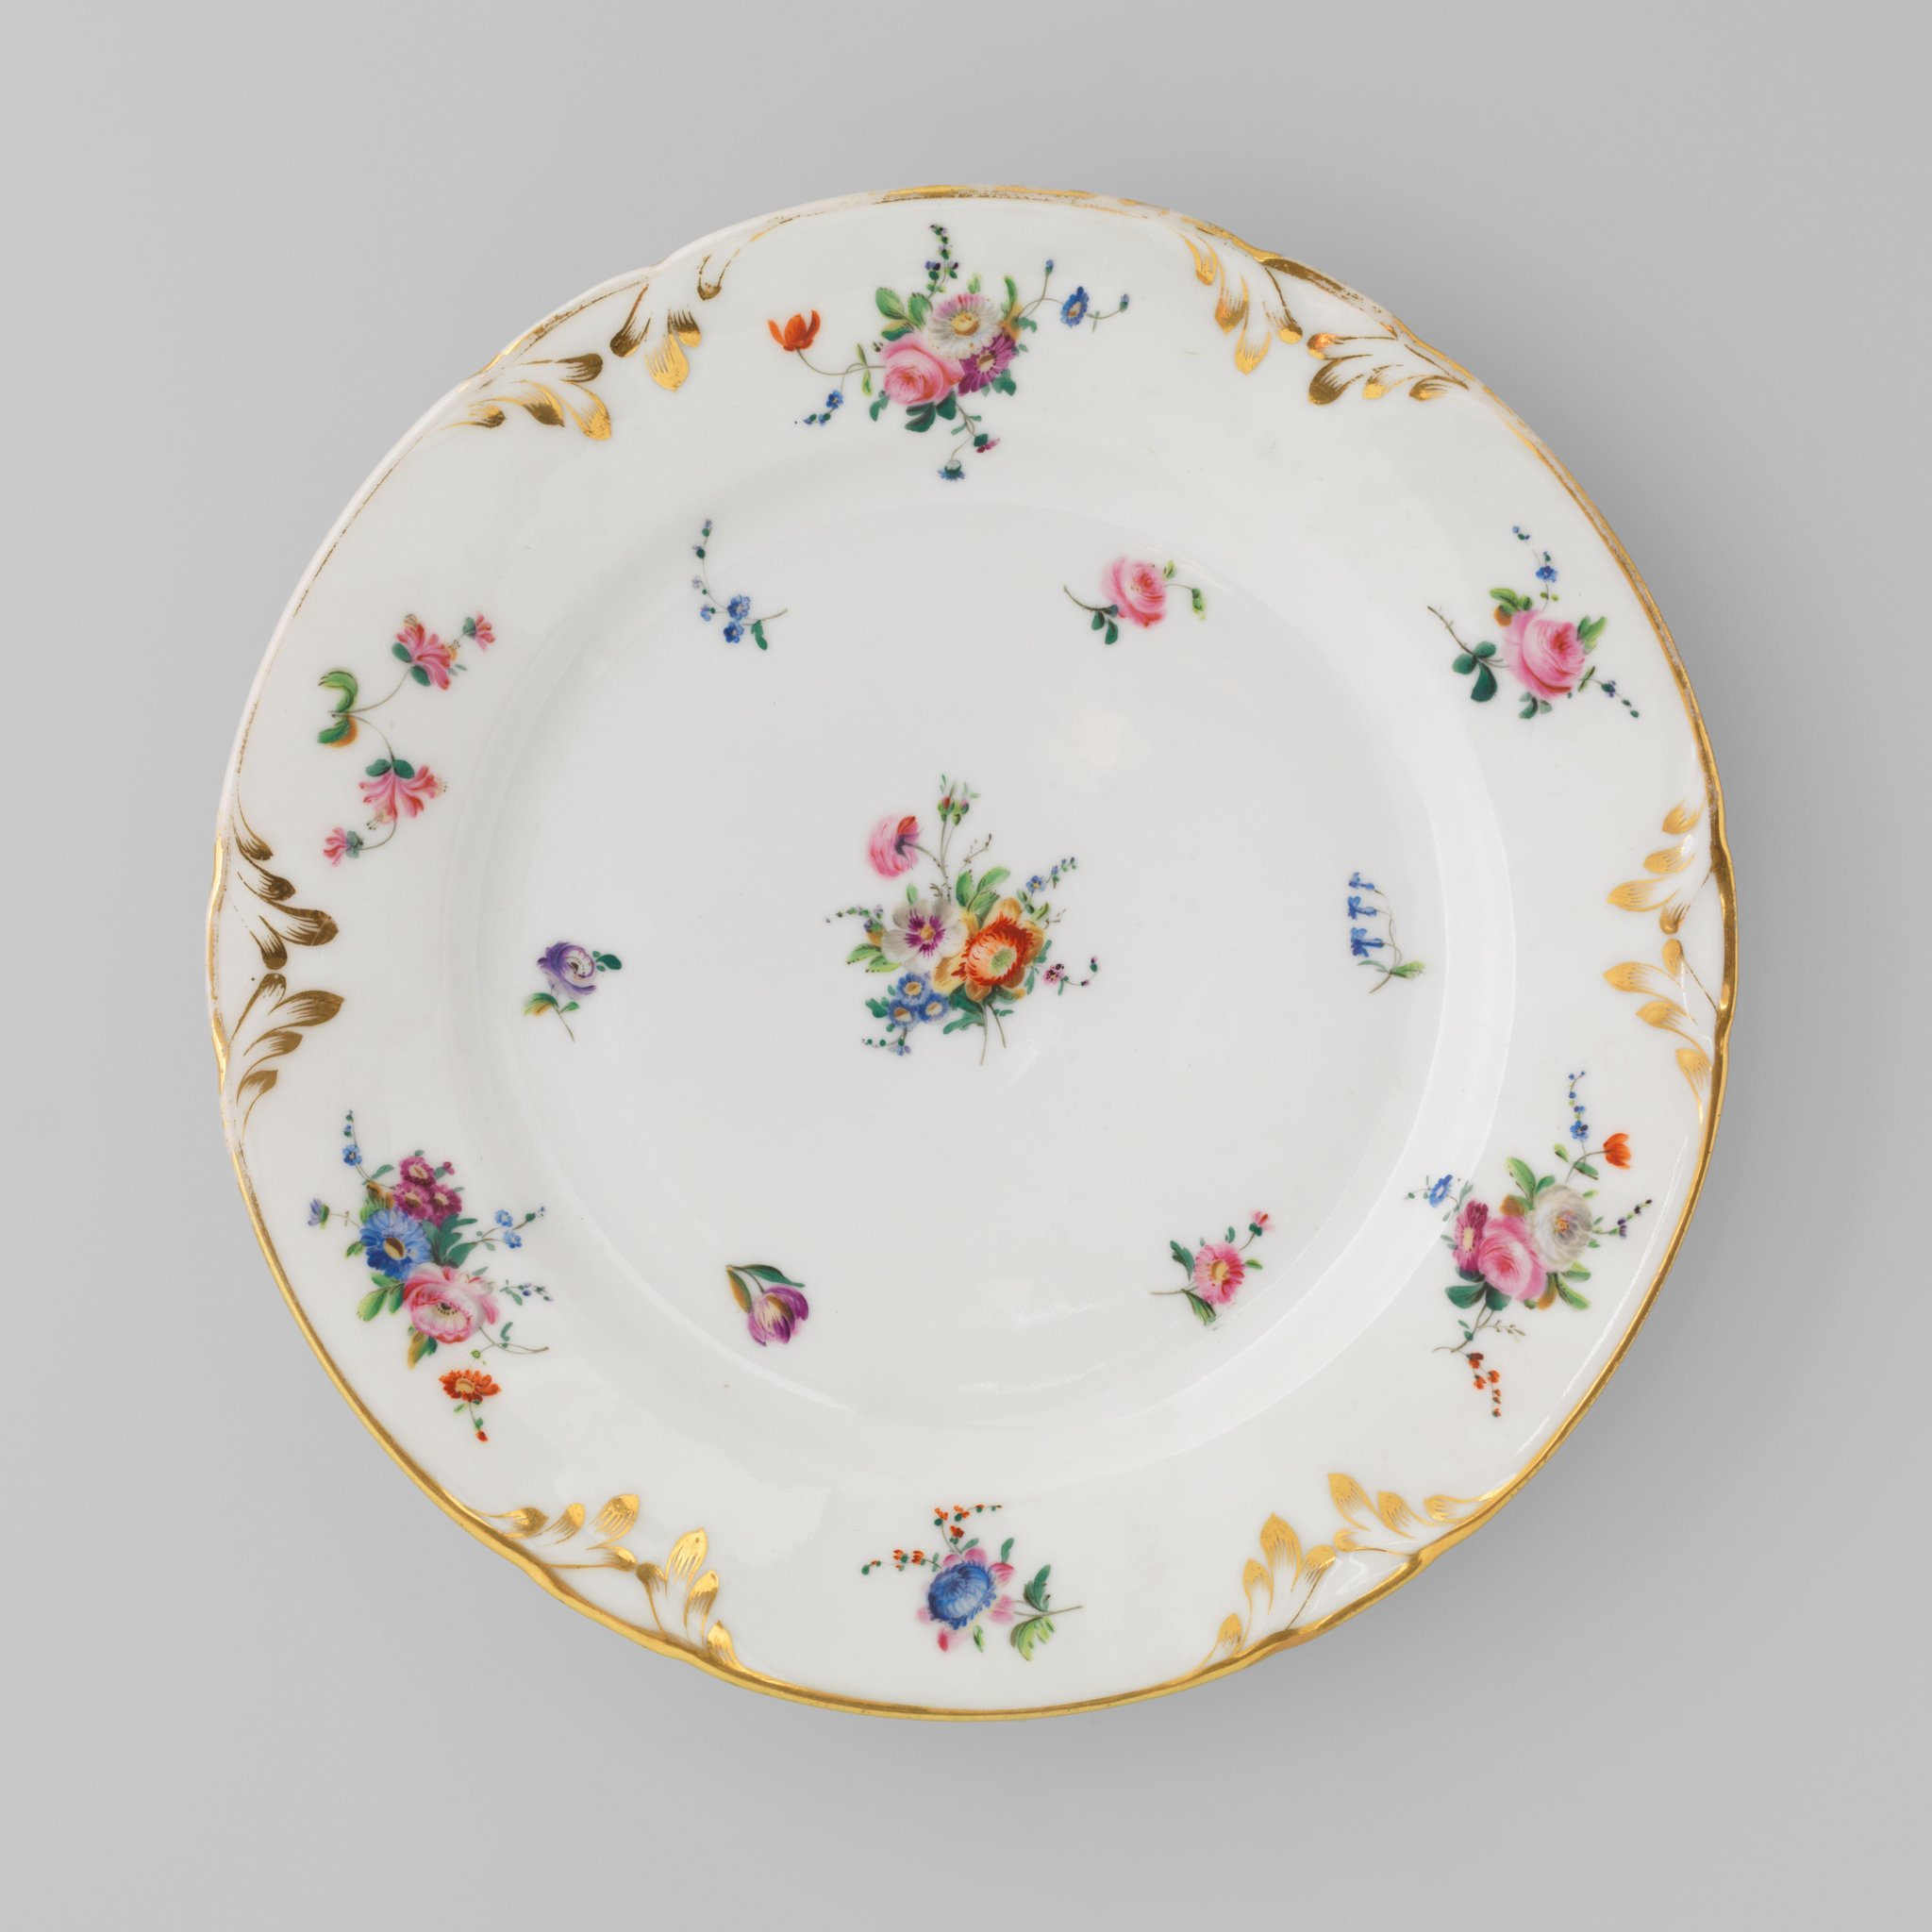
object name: service set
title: Plate with bouquets and flower sprays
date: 1839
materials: glaze, gold, paint, porcelain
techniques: firing, forming, gilding, turning, vitrification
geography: paris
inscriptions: mark: ‘DENUELLE/ Boulevard St. Denis 18/ à Paris’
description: Bord (dessertbord) van porselein met een gelobde rand, beschilderd op het glazuur in blauw, rood, roze, groen, geel, paars, zwart en goud. Op het plat boeketten van verschillende bloemen en strooibloemen. Vanuit de gelobde, gouden rand, gemodelleerde bladranken in reliëf, aangezet met goud. Hiertussen boeketten. Drie proenen op de onderzijde. Gemerkt op de onderzijde met 'DENUELLE/ Boulevard St. Denis 18/ à Paris'.